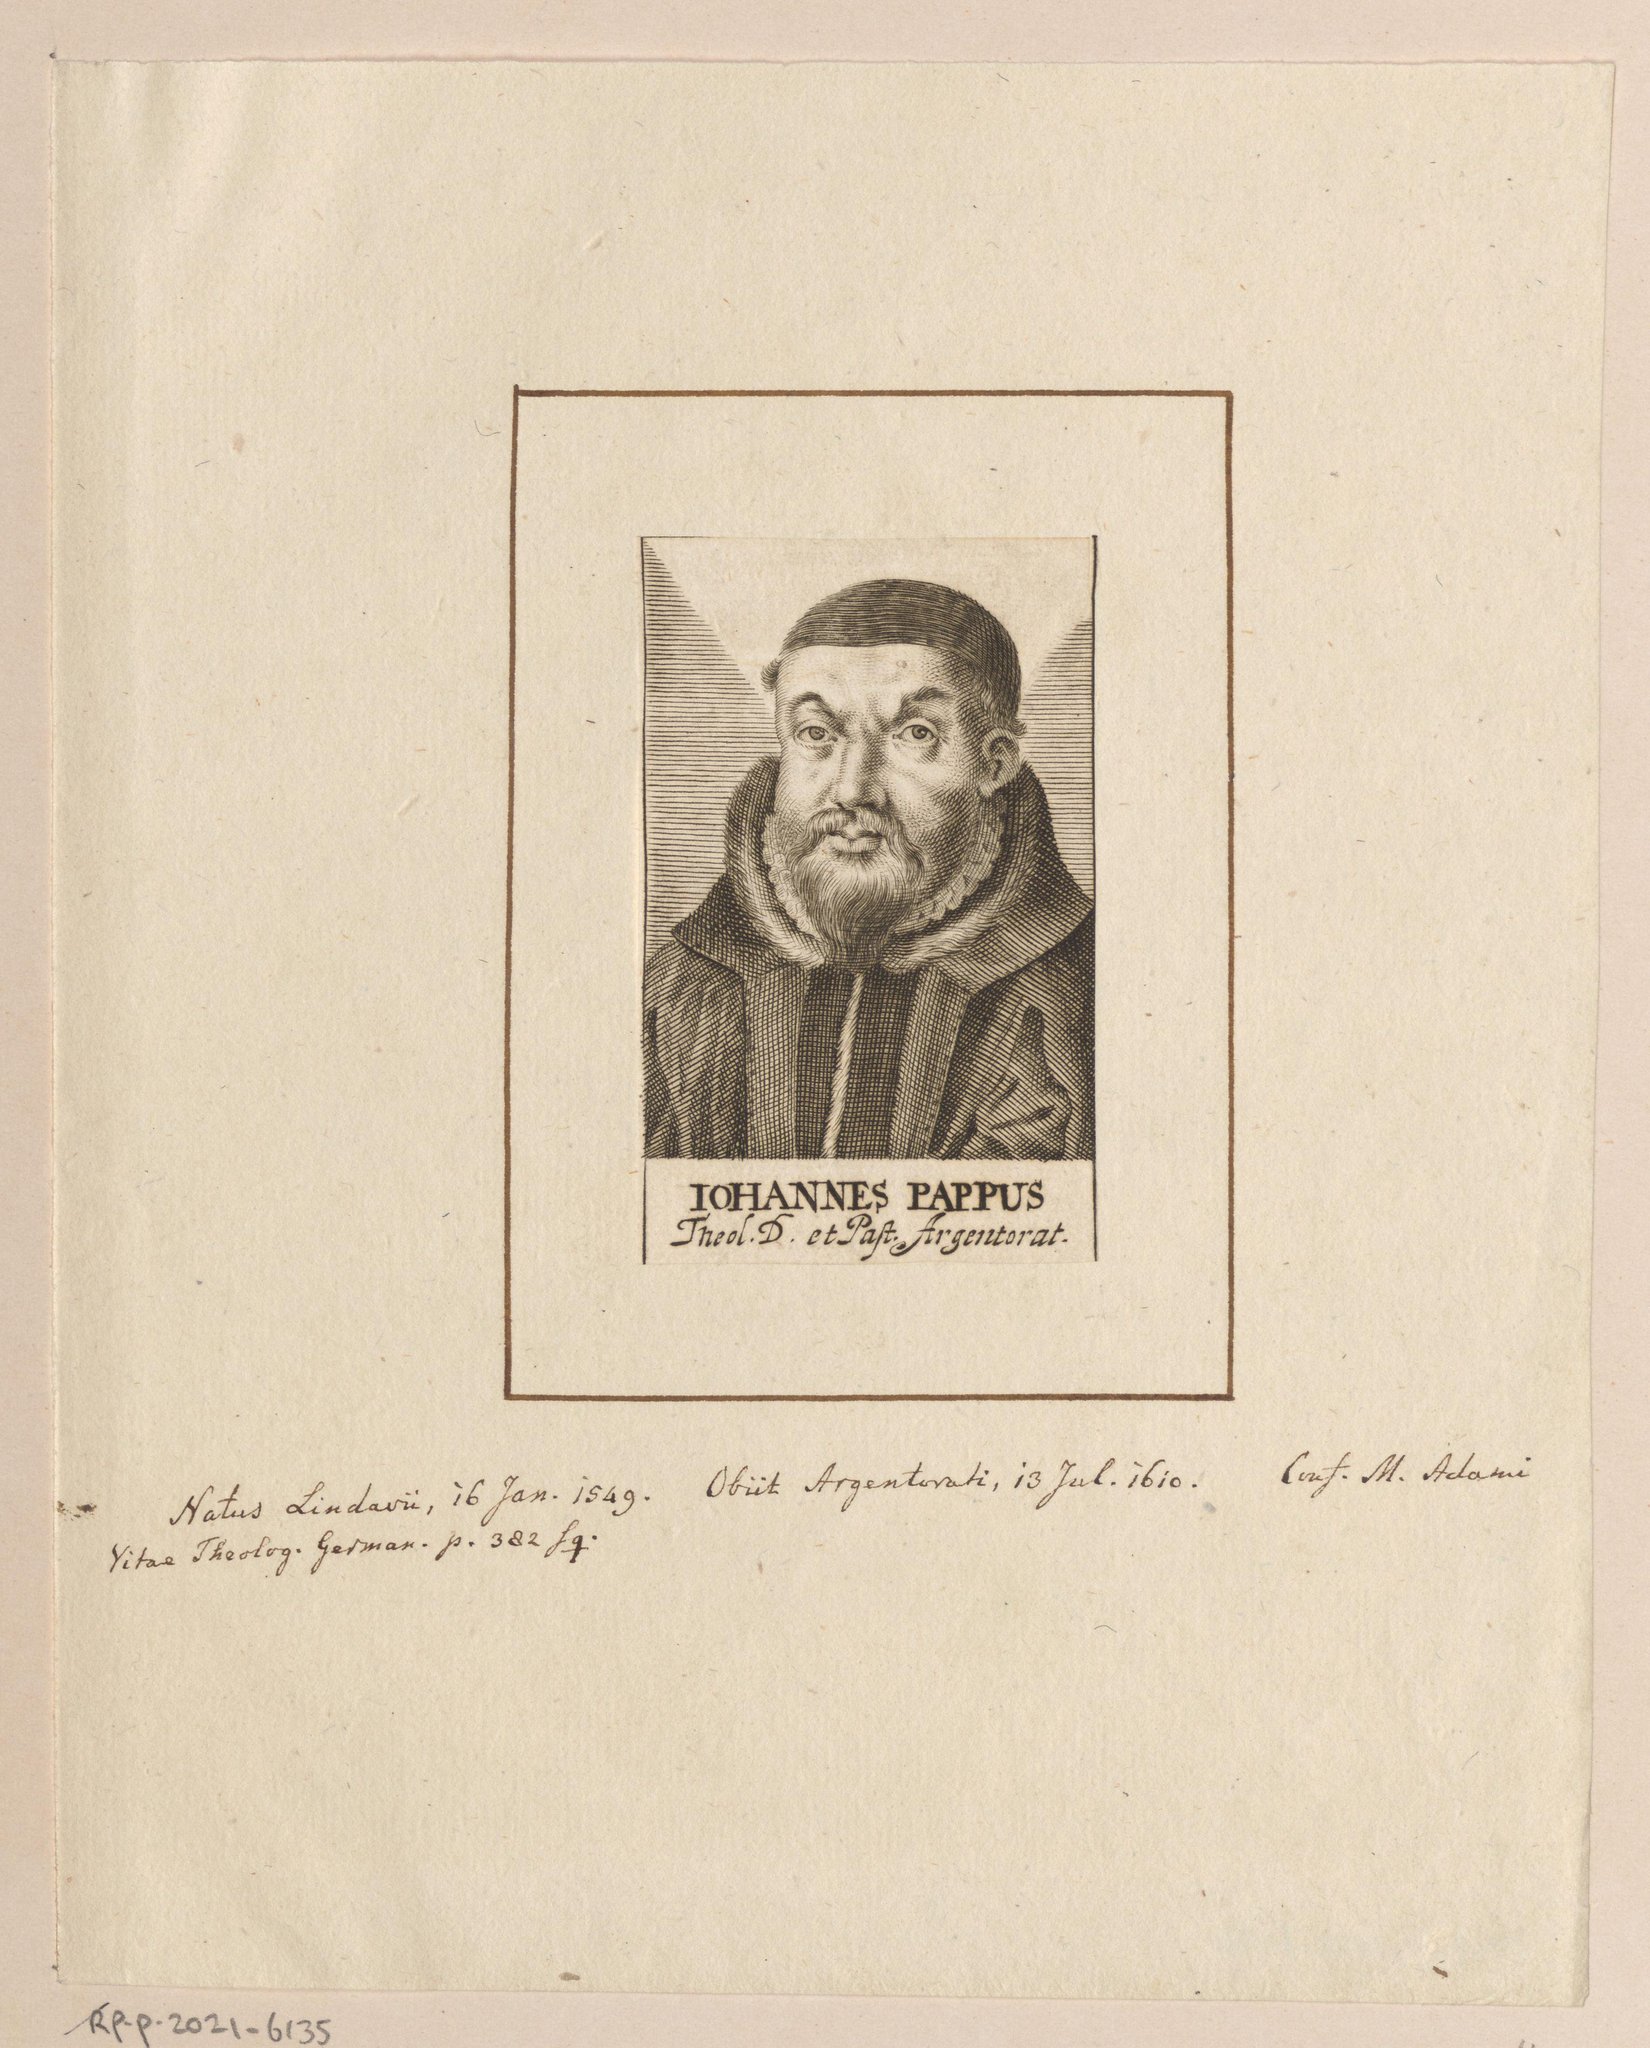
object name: book illustration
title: Portret van Johannes Pappus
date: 1688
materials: paper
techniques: engraving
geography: nuremberg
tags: adult man, historical persons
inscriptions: inscription: ‘Natus Lindarii, 16 jan. 1549 (...) Vitae Theolog. German. p. 382 fq.’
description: Prent uit: Freher, Paul. Theatrum virorum eruditione clarorum. Neurenberg: Johann Hoffmann, 1688.